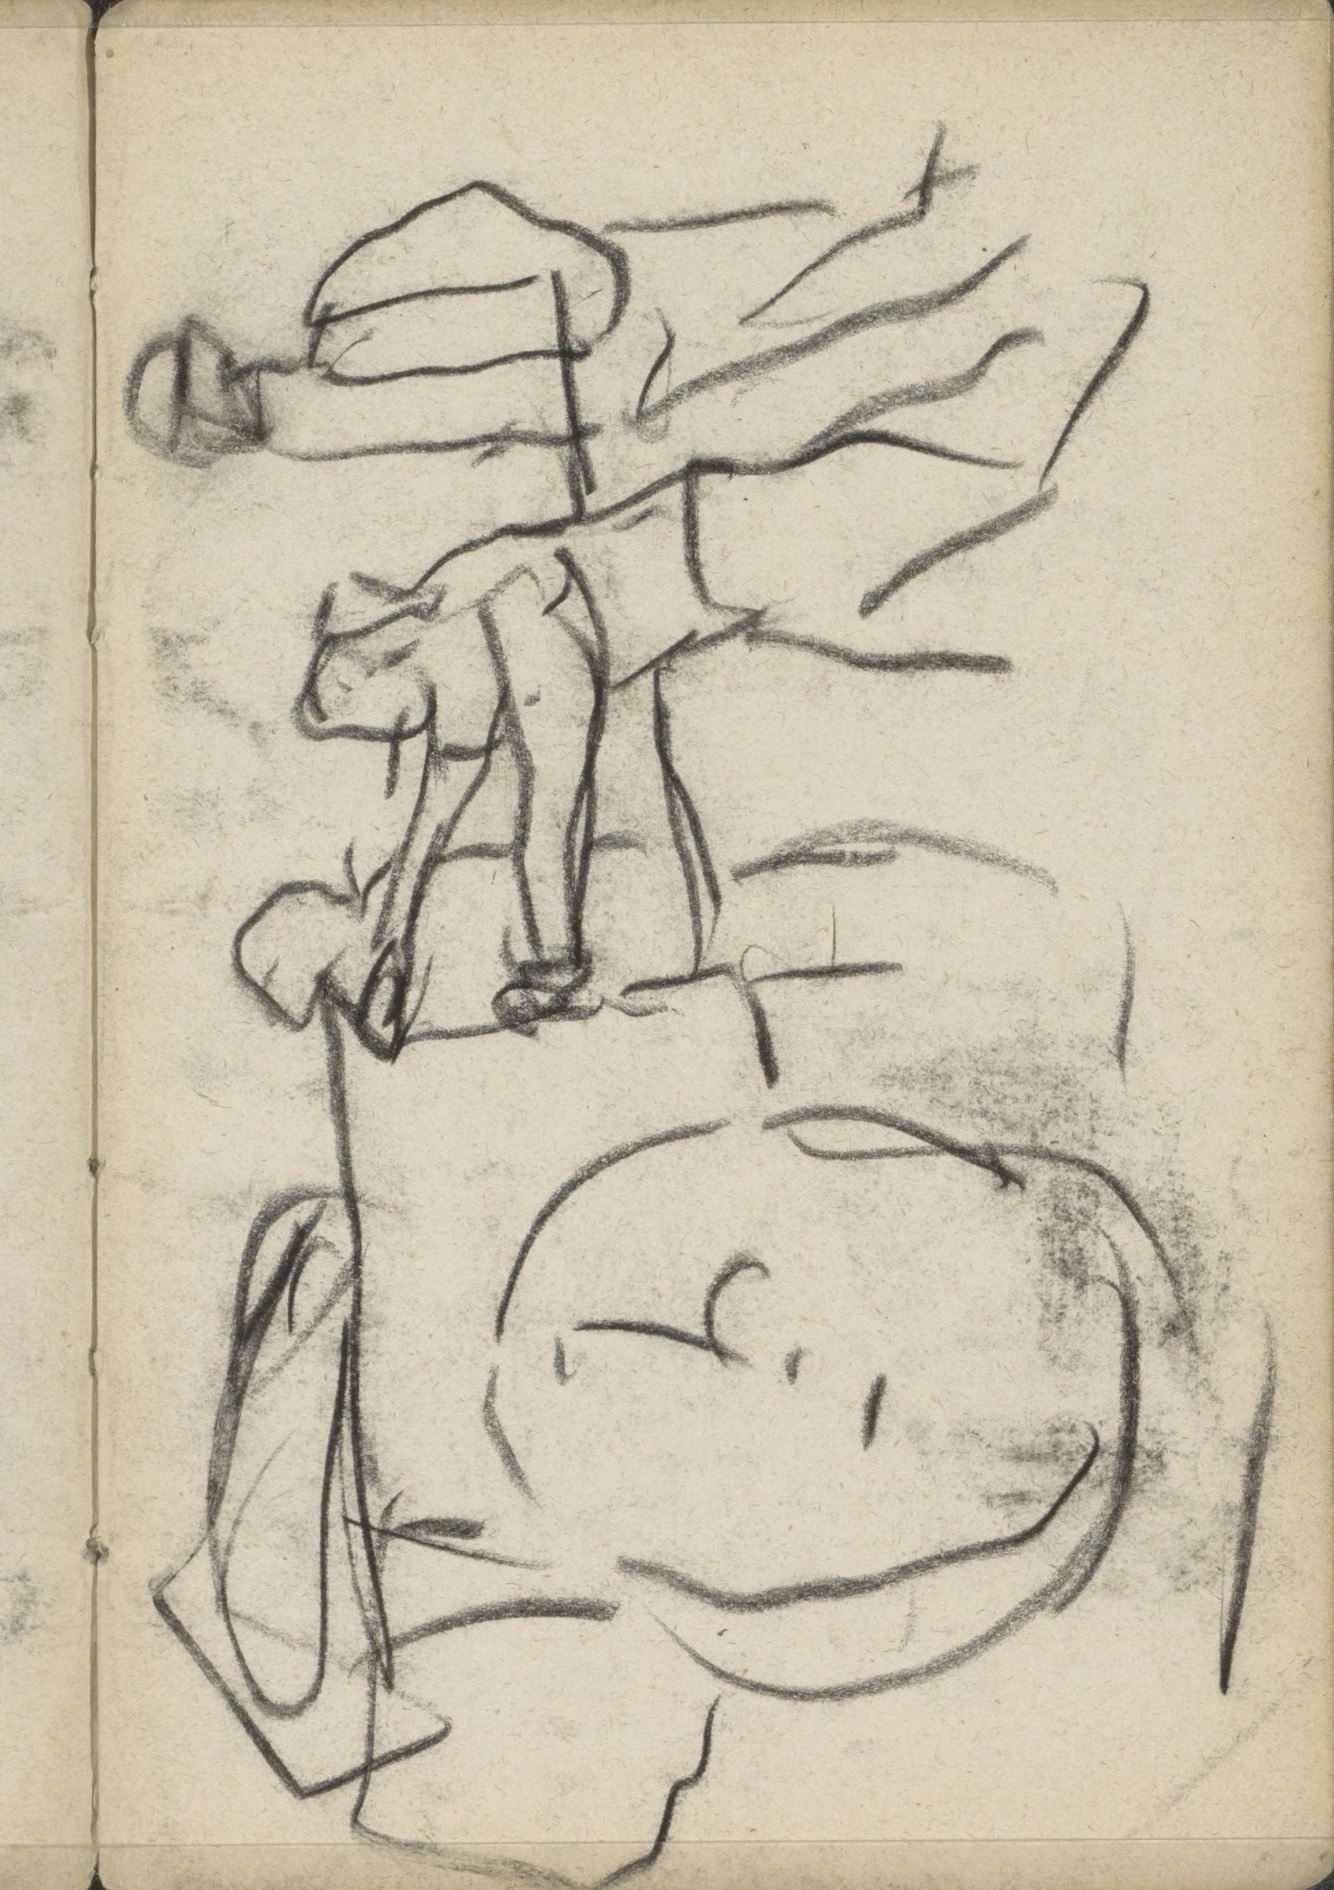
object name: sketchbook leaf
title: Drie grondkruiers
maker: george hendrik breitner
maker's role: draughtsman, painter, print maker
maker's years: 1857-1923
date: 1900-1901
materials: chalk, paper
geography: amsterdam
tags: porter, bearer (+ three persons ~ traffic and transport)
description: Drie grondkruiers. Pagina 74 uit een schetsboek met 46 bladen vervaardigd te Amsterdam.